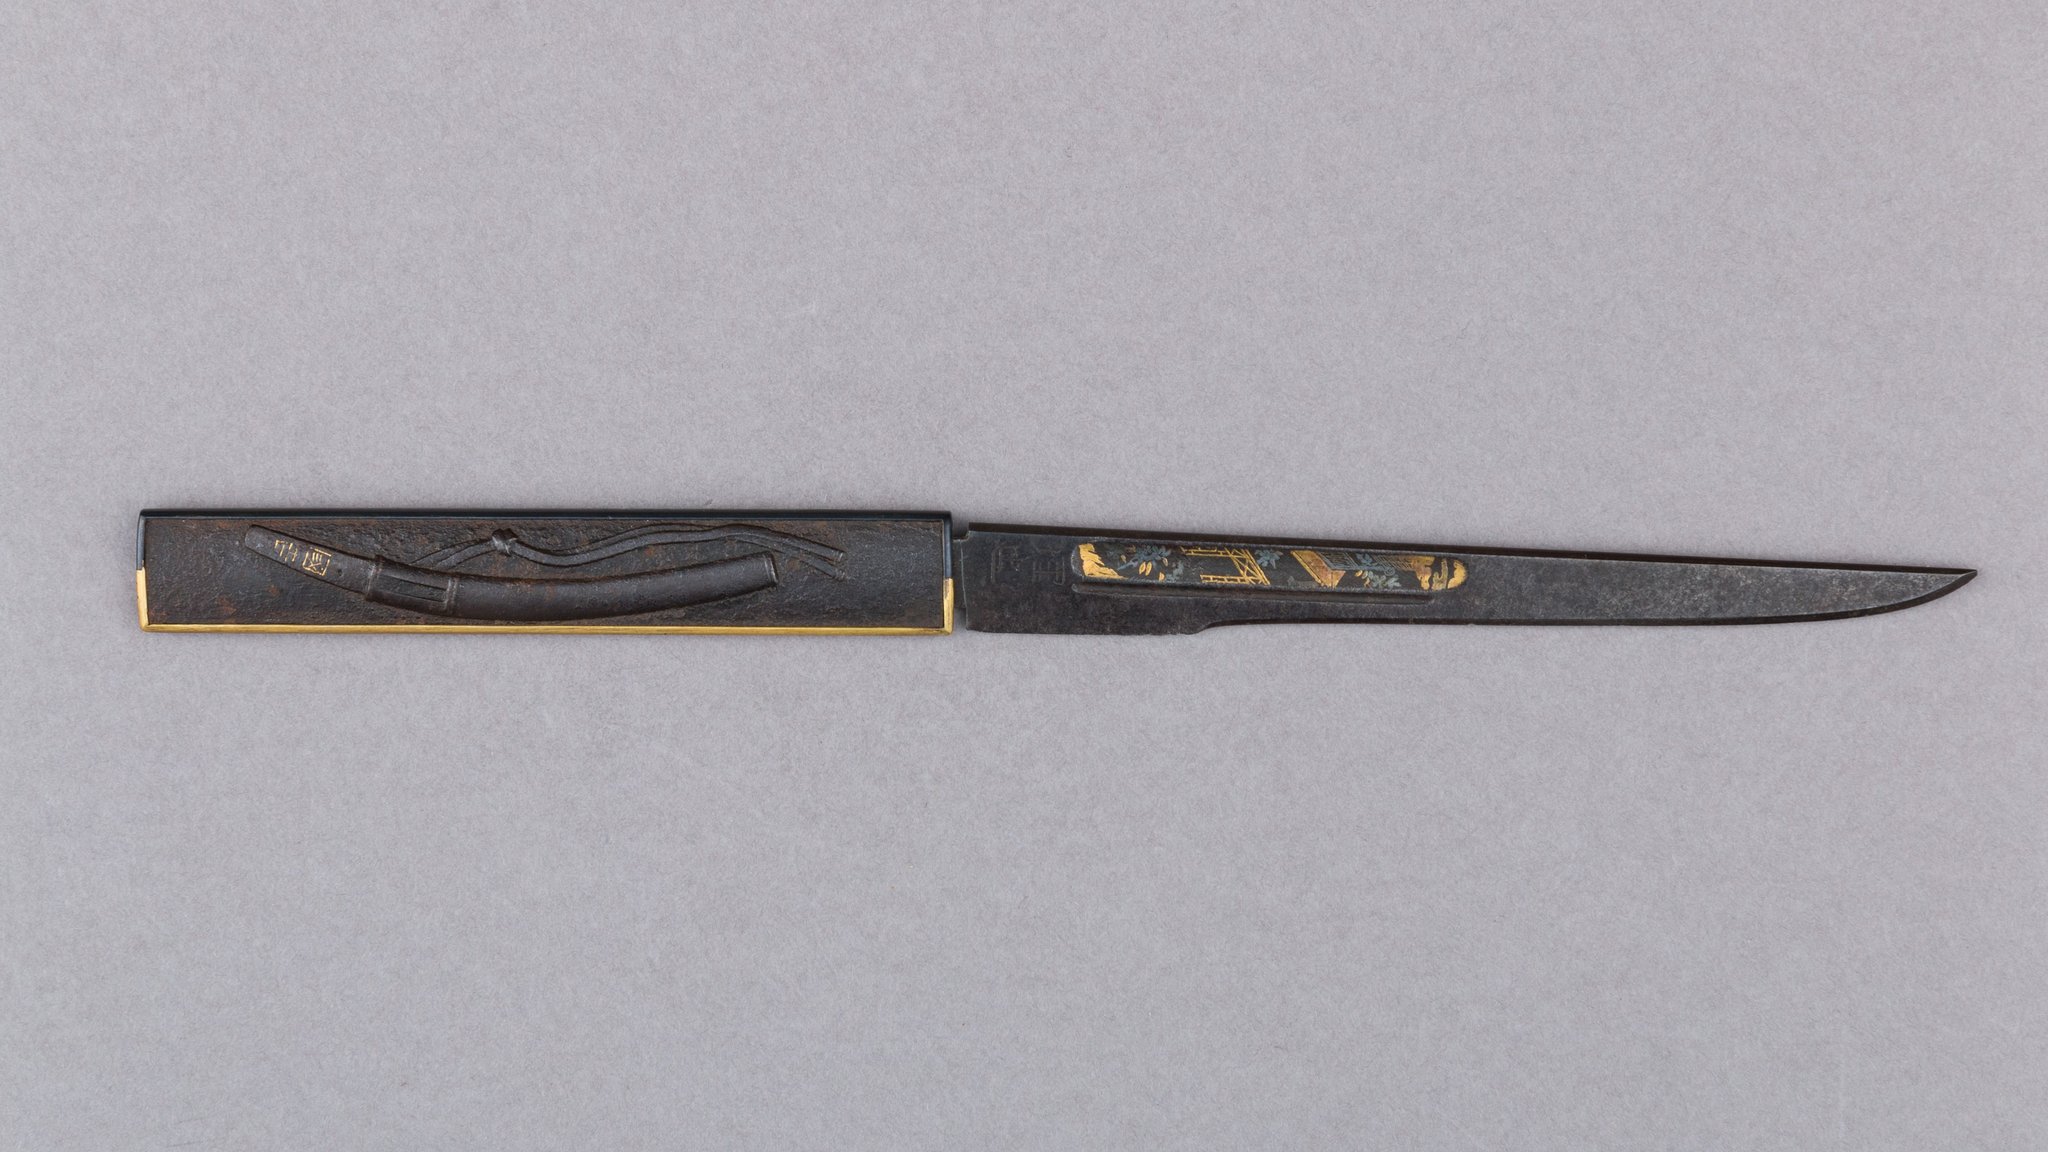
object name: knife handle kozuka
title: Knife Handle (Kozuka) with Blade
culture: japanese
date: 1601-1700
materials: gold alloy, gold, iron, silver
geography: japan